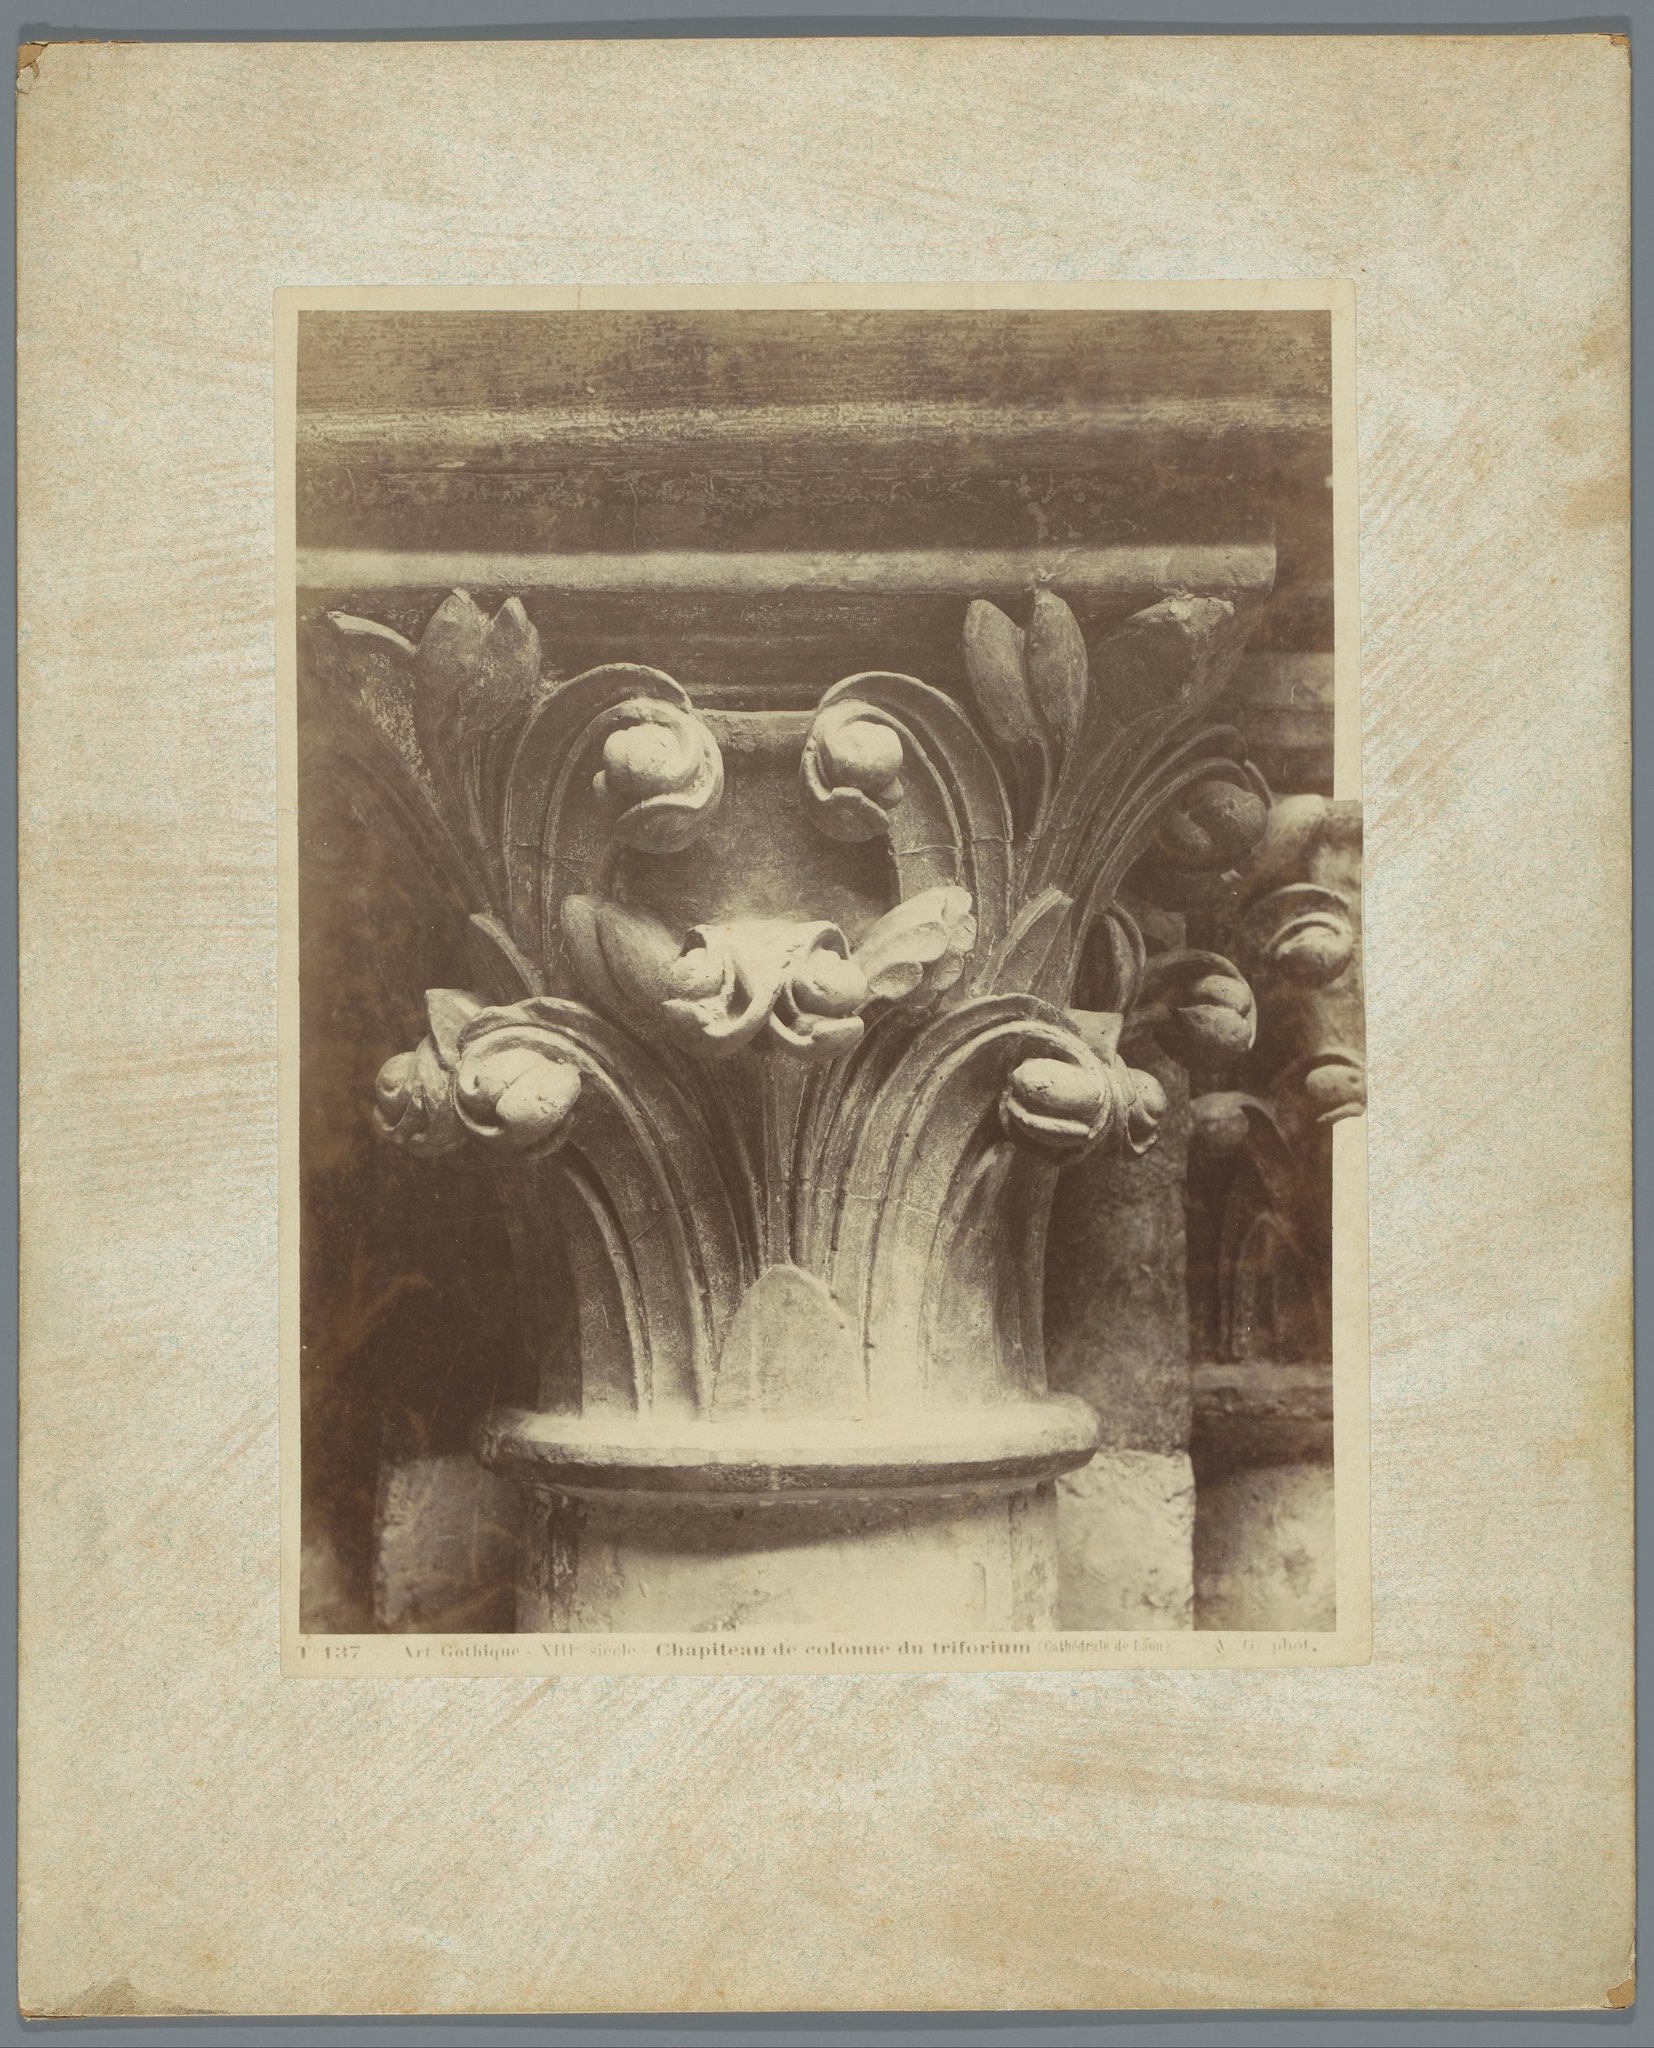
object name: photograph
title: Art Gothique - XIII siècle - Chapiteau de colonne du triforium (Cathédrale de Laon)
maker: adolphe giraudon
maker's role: publisher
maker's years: 1849-1929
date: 1875-1900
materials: cardboard, photographic support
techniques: albumen print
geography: laon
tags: acanthus ~ ornament, capital (~ column, pillar)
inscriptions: collector's mark: ‘RIJKS-NORMAALSCHOOL voor TEEKENONDERWIJZERS AMSTERDAM’, number: ‘T 137’